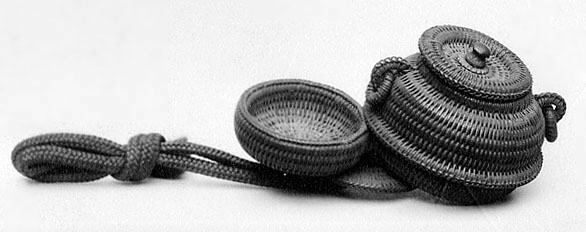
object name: netsuke basket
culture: japanese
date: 1801-1900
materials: bamboo